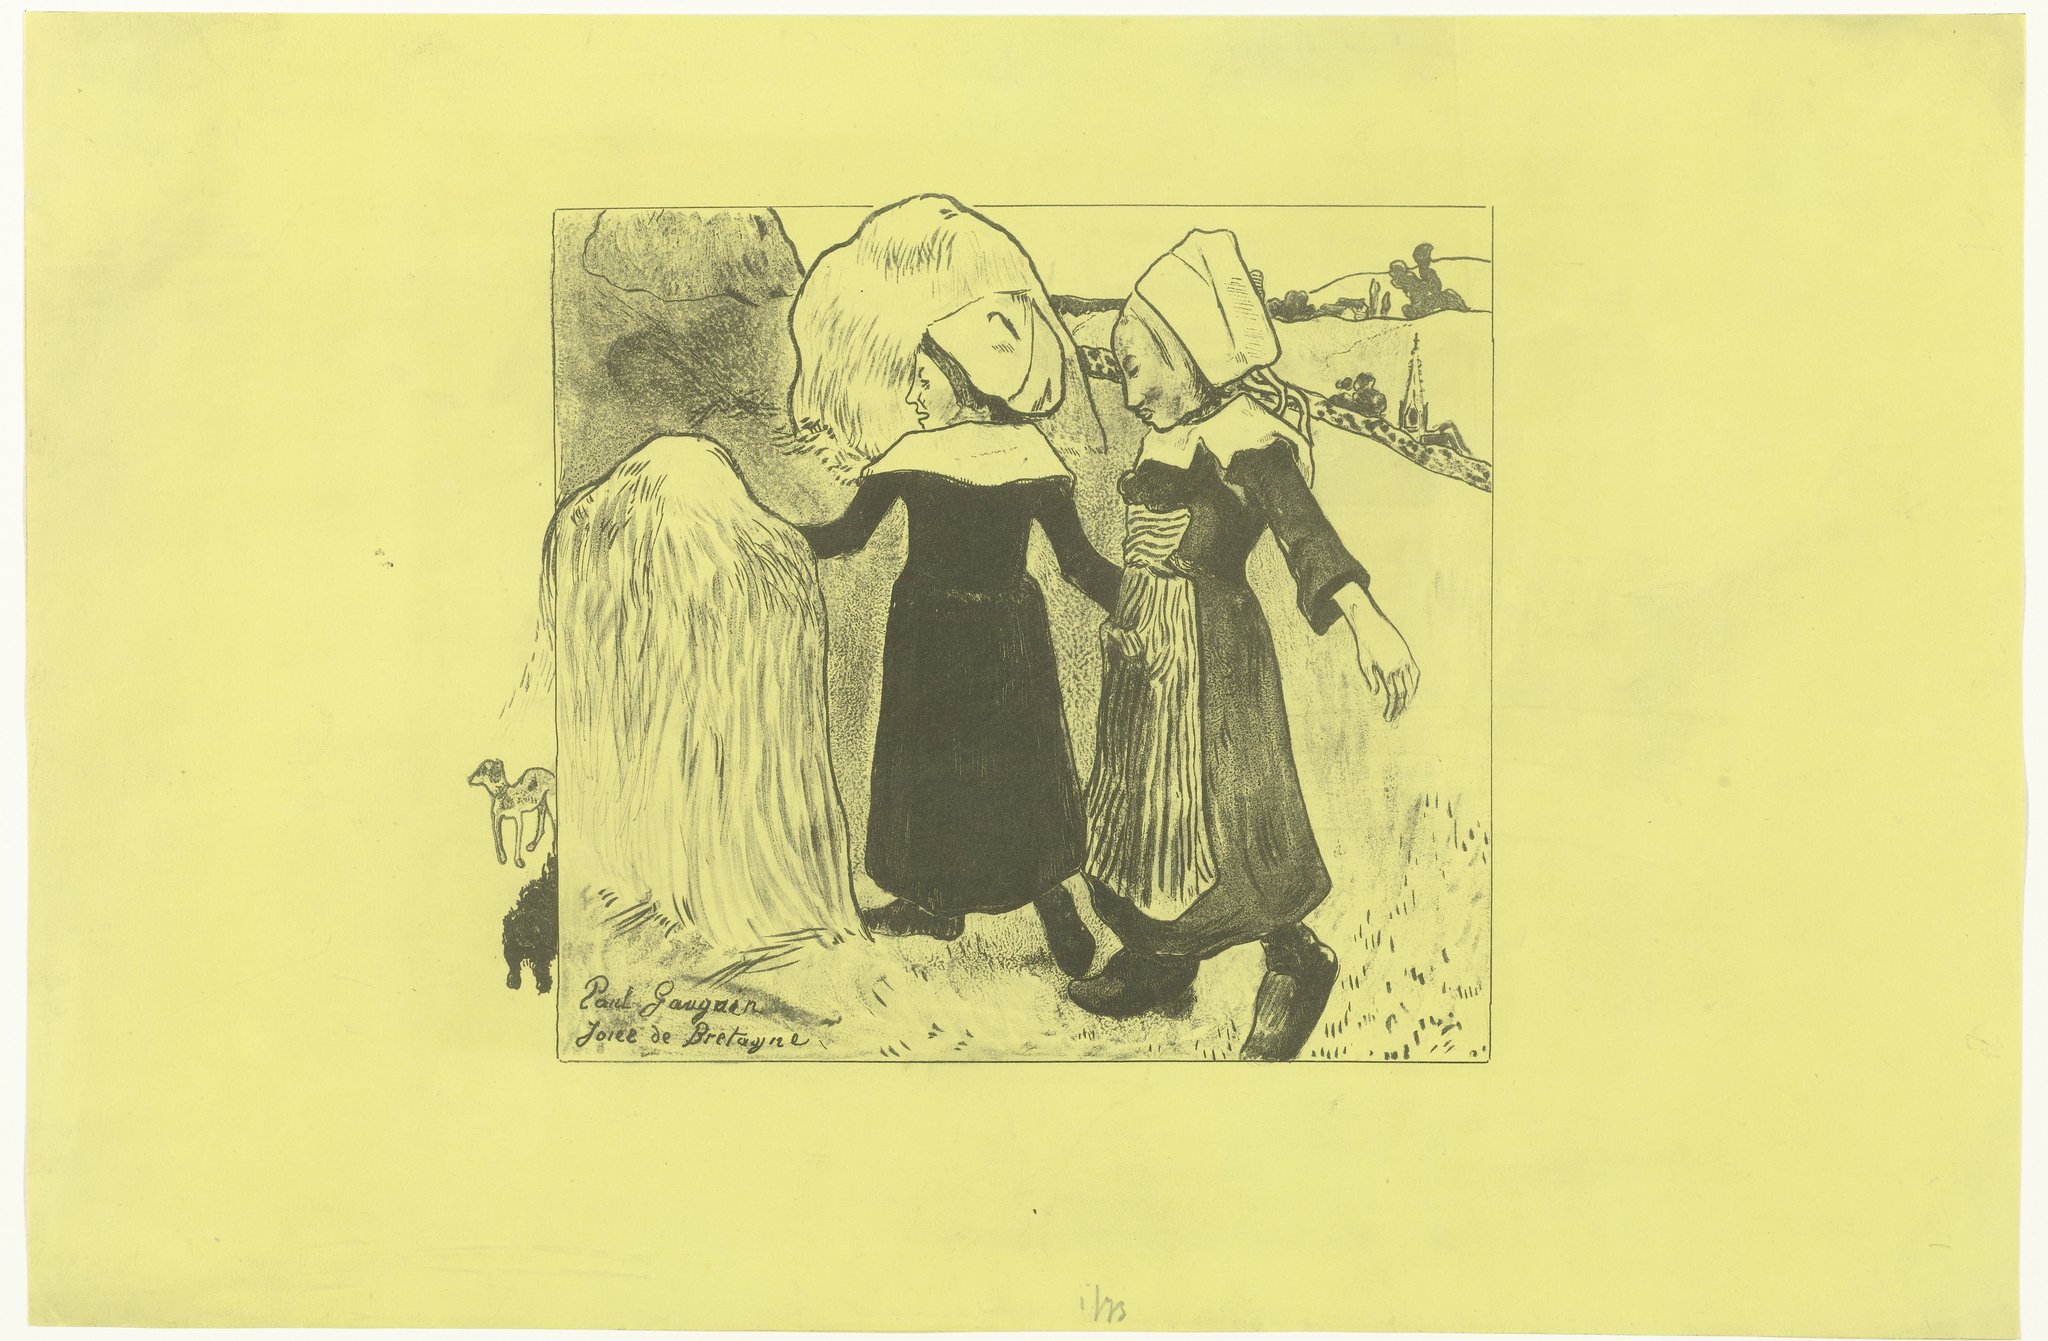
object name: print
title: Twee boerinnen met mutsen bij hooibergen op het land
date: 1889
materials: paper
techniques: lithography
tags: bretagne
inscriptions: collector's mark: Lugt 2228, collector's mark: Lugt 2760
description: Deze prent werd in deze staat gedrukt in een oplage van dertig tot vijfitg exemplaren.